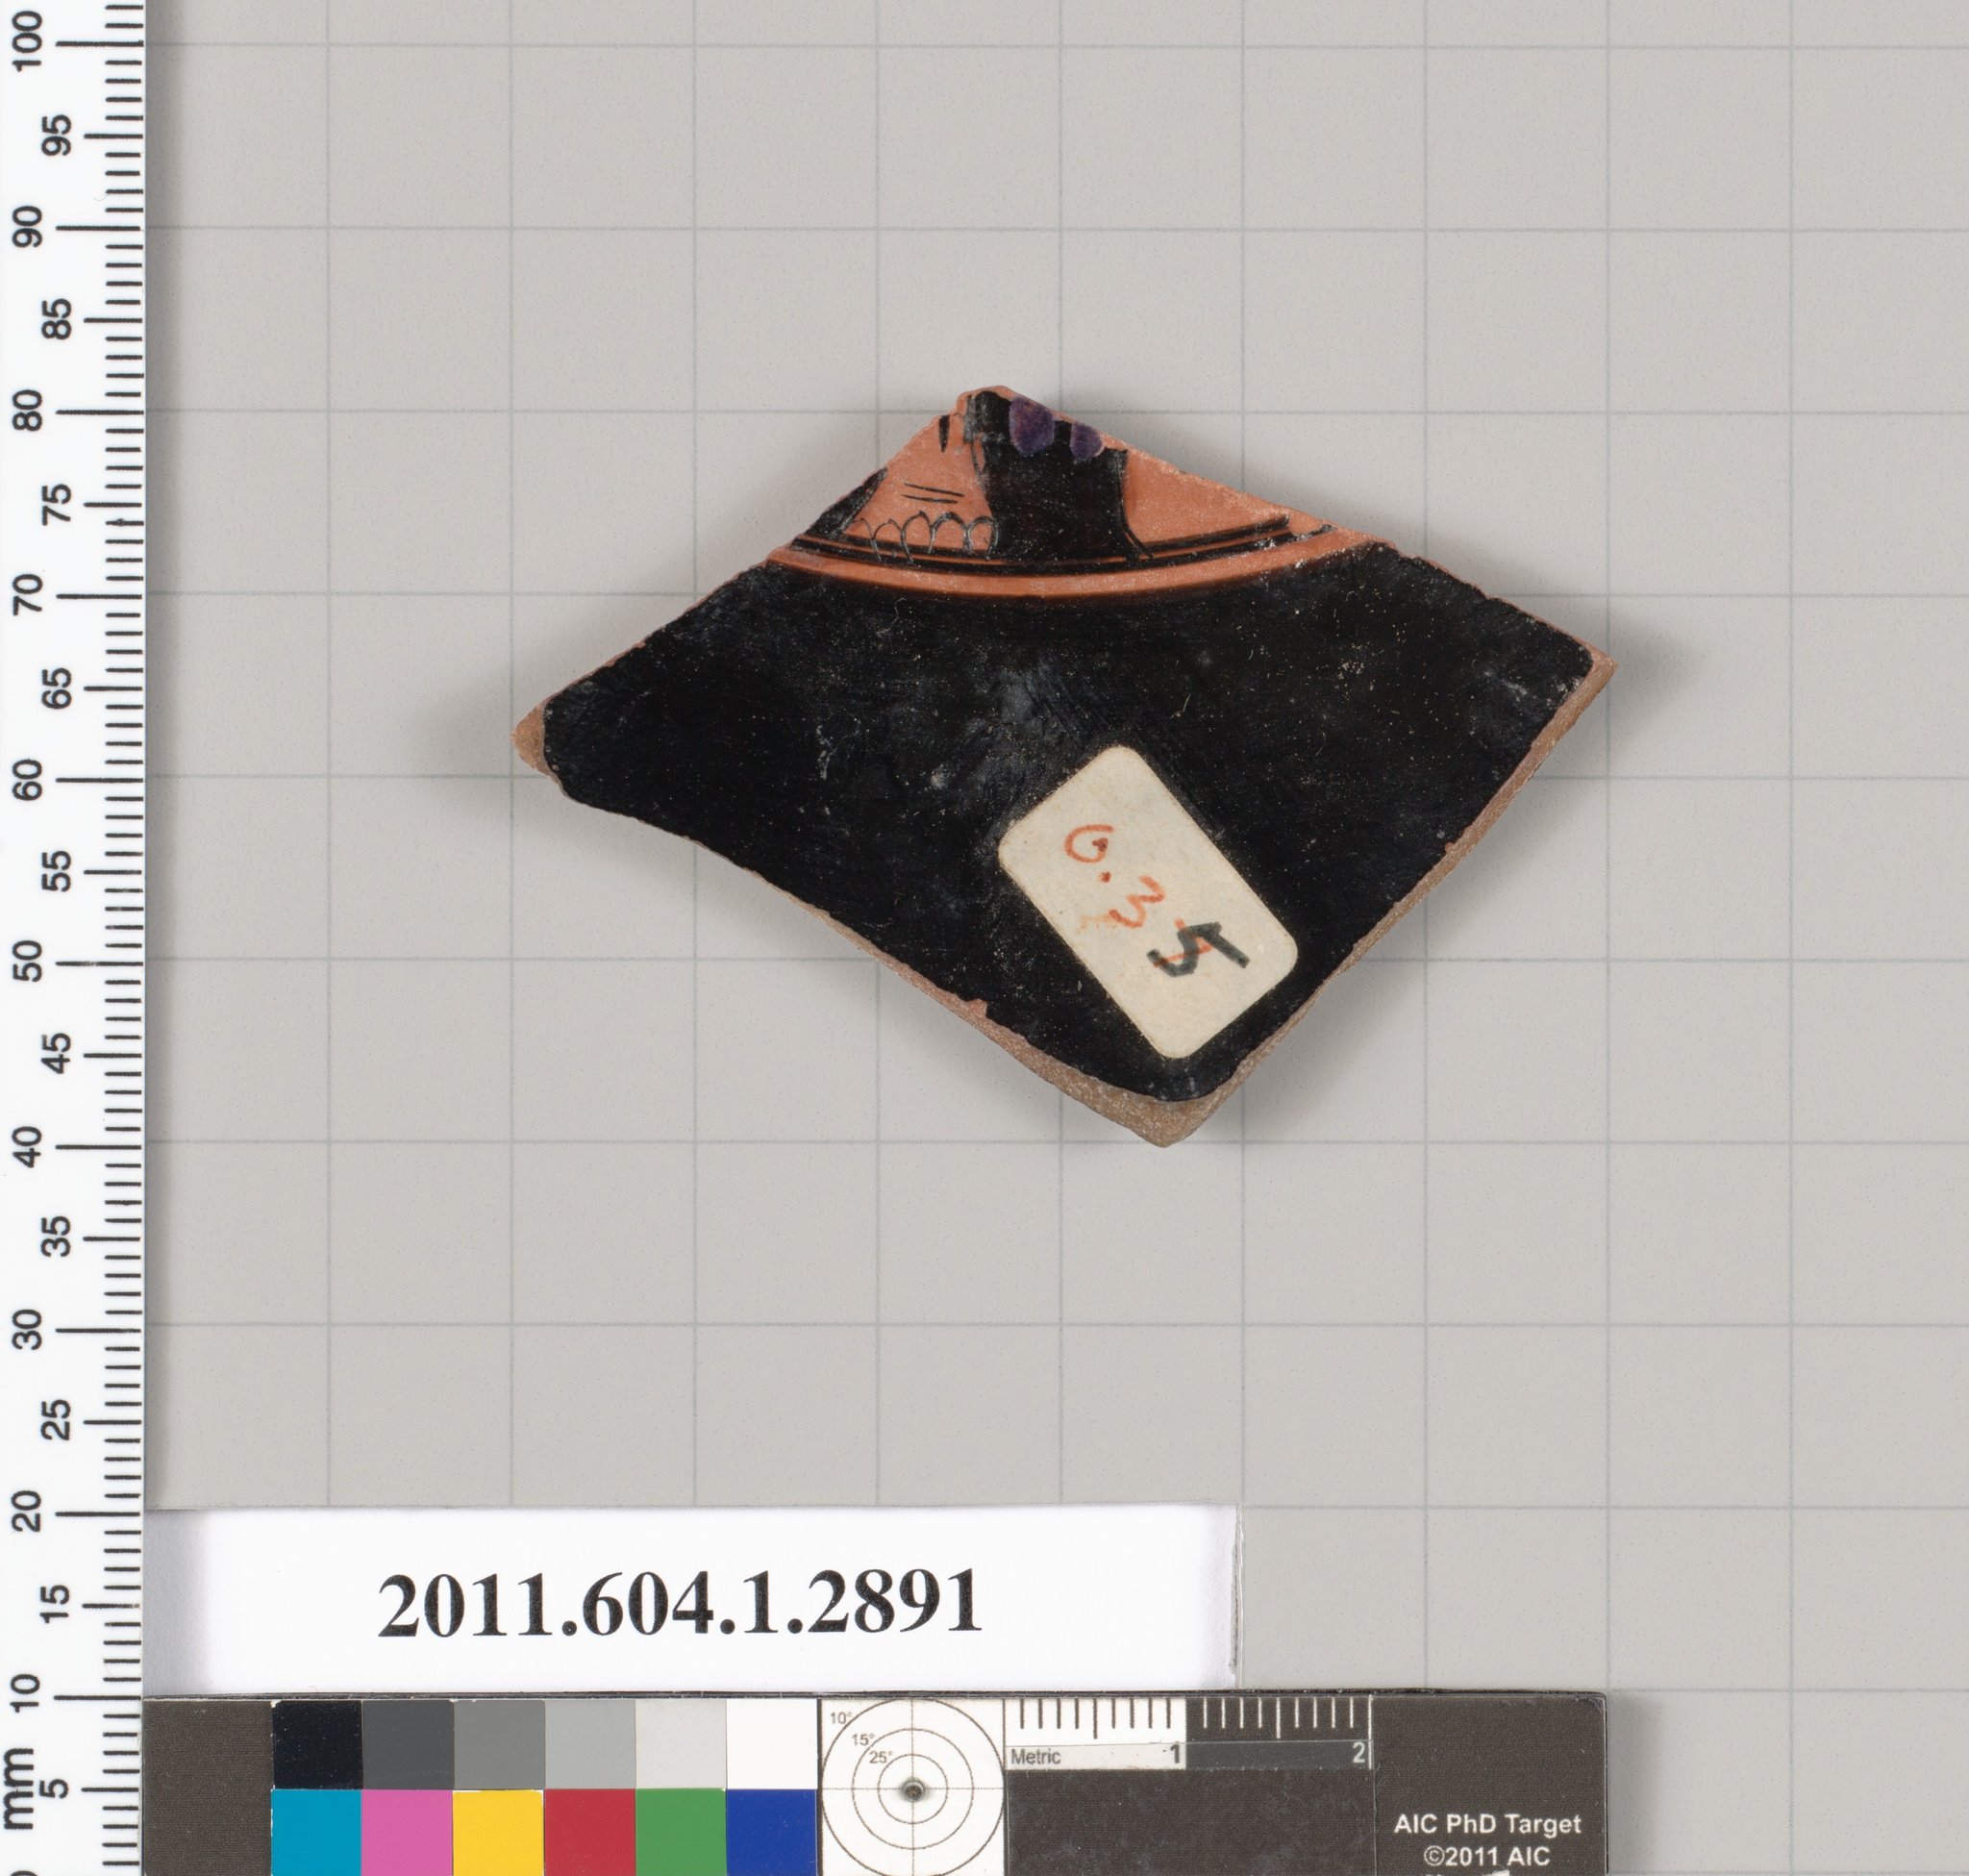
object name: kylix fragment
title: Terracotta fragment of a kylix (drinking cup)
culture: greek, attic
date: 510-490 BCE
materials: terracotta